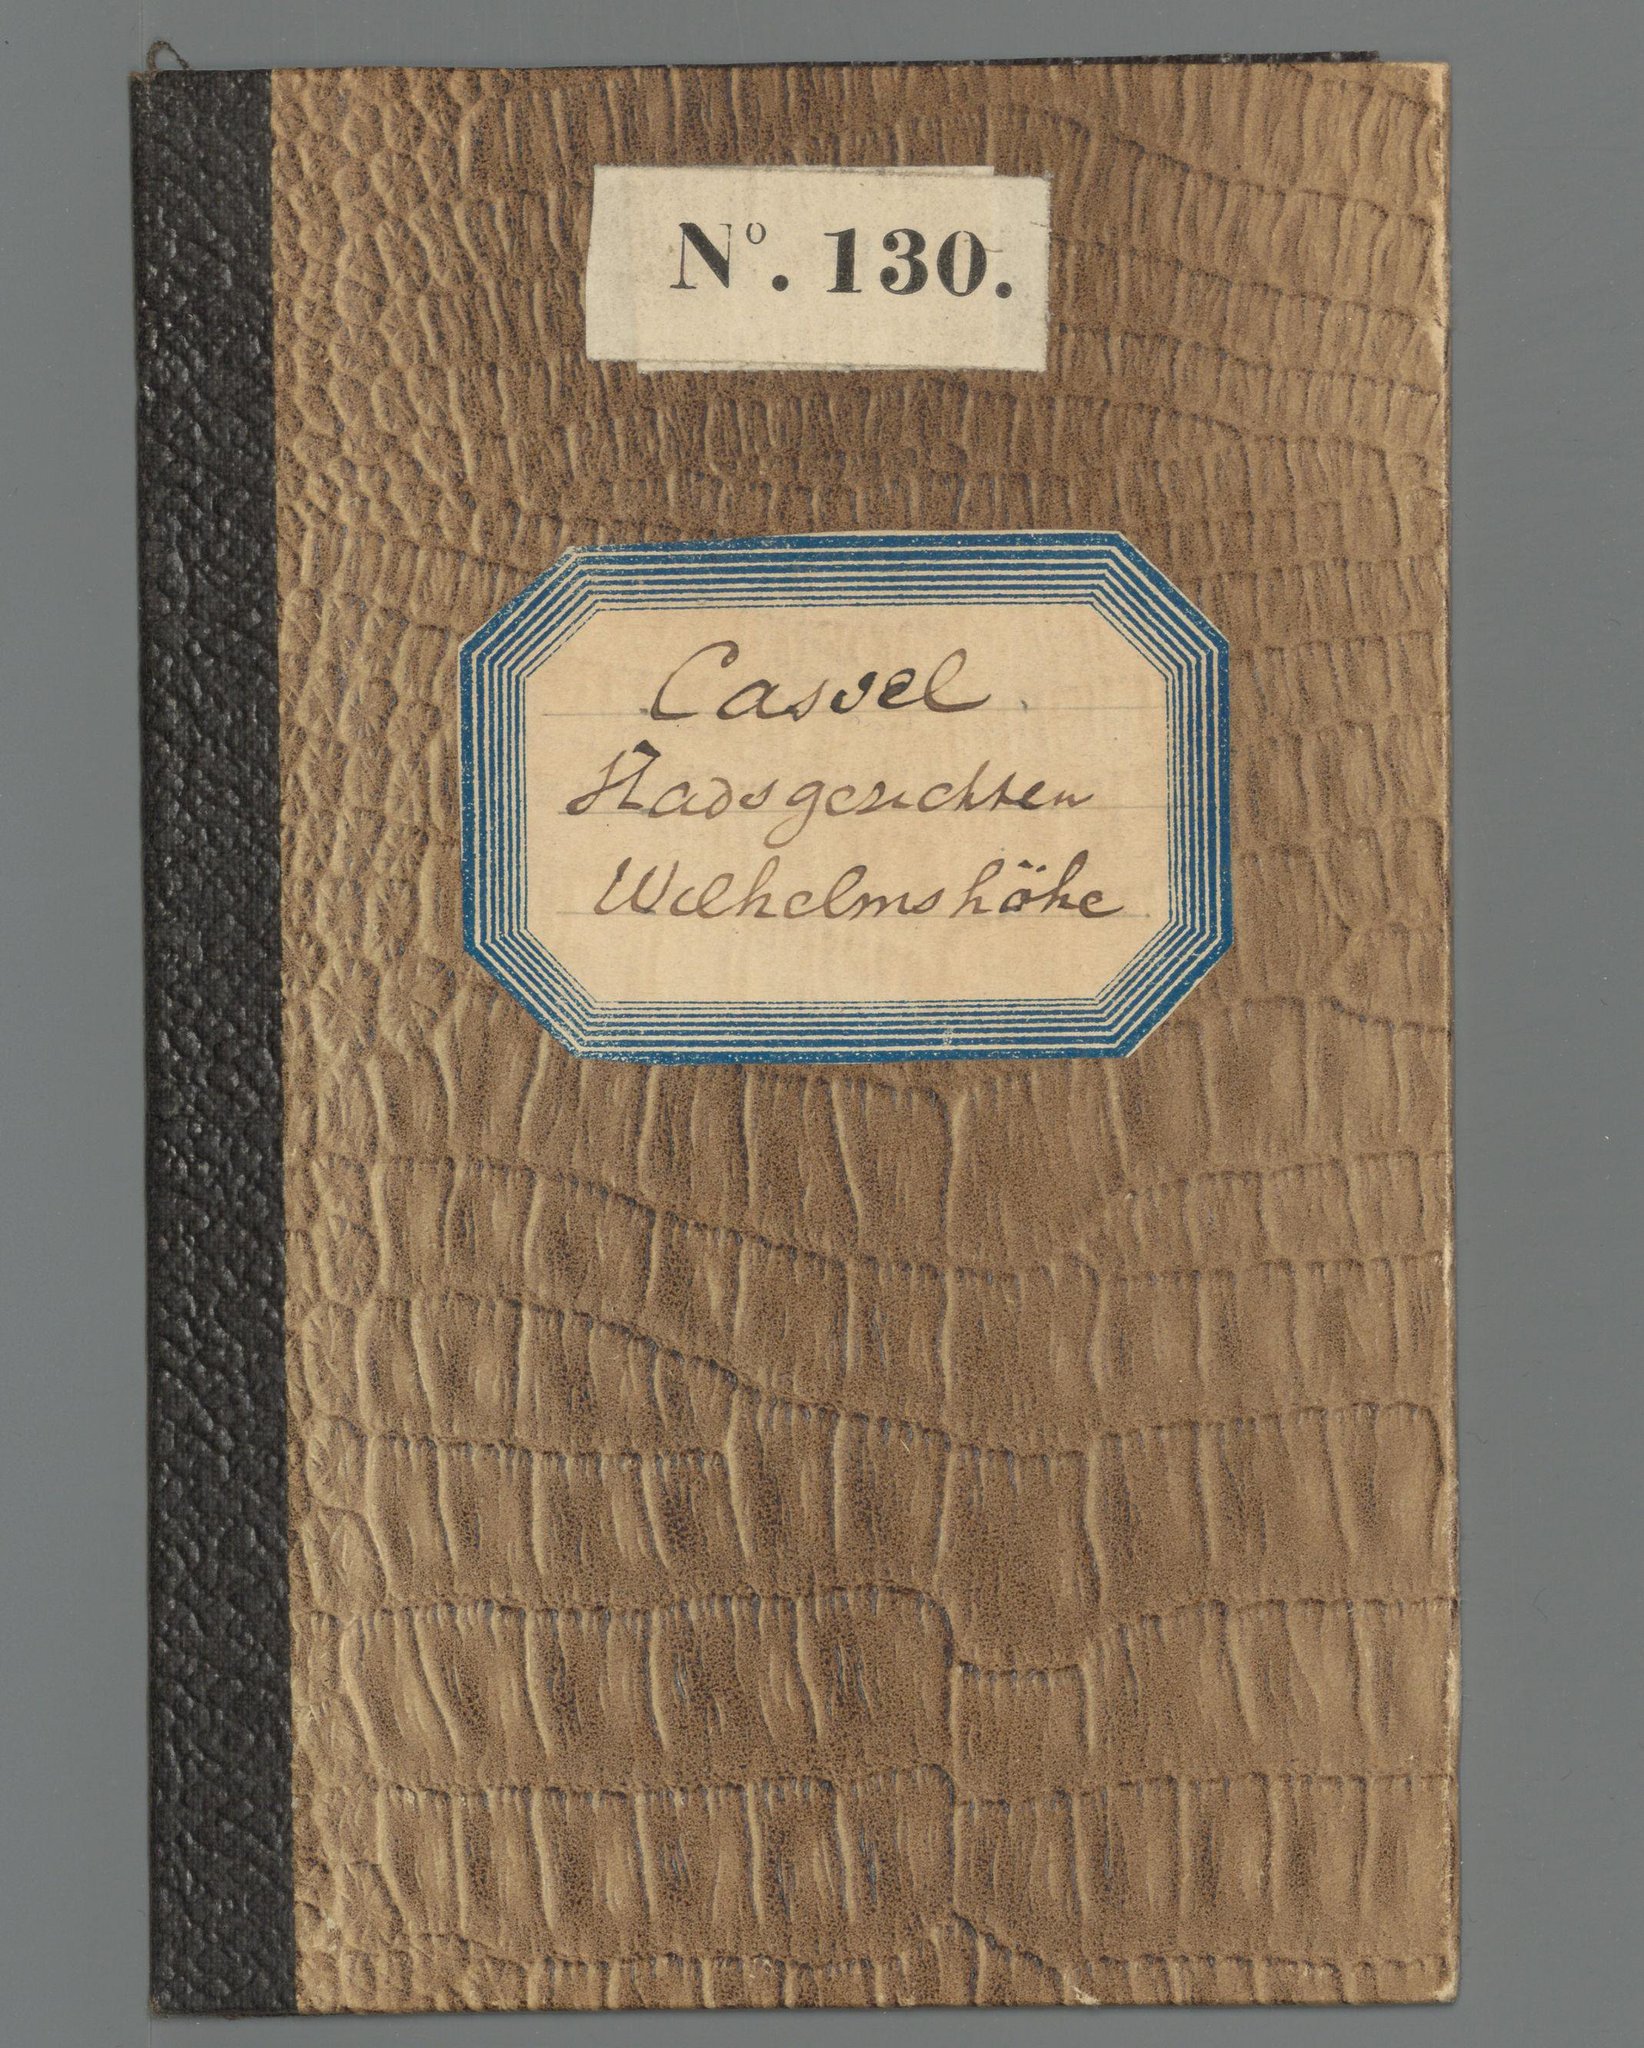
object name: wrapper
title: Omslag voor tien prentbriefkaarten met stadsgezichten uit Kassel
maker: Anonymous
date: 1900-1950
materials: cardboard, paper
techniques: lithograph, writing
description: In de omslag zit een kaart ingestoken met daarop een korte beschrijving van de inhoud.